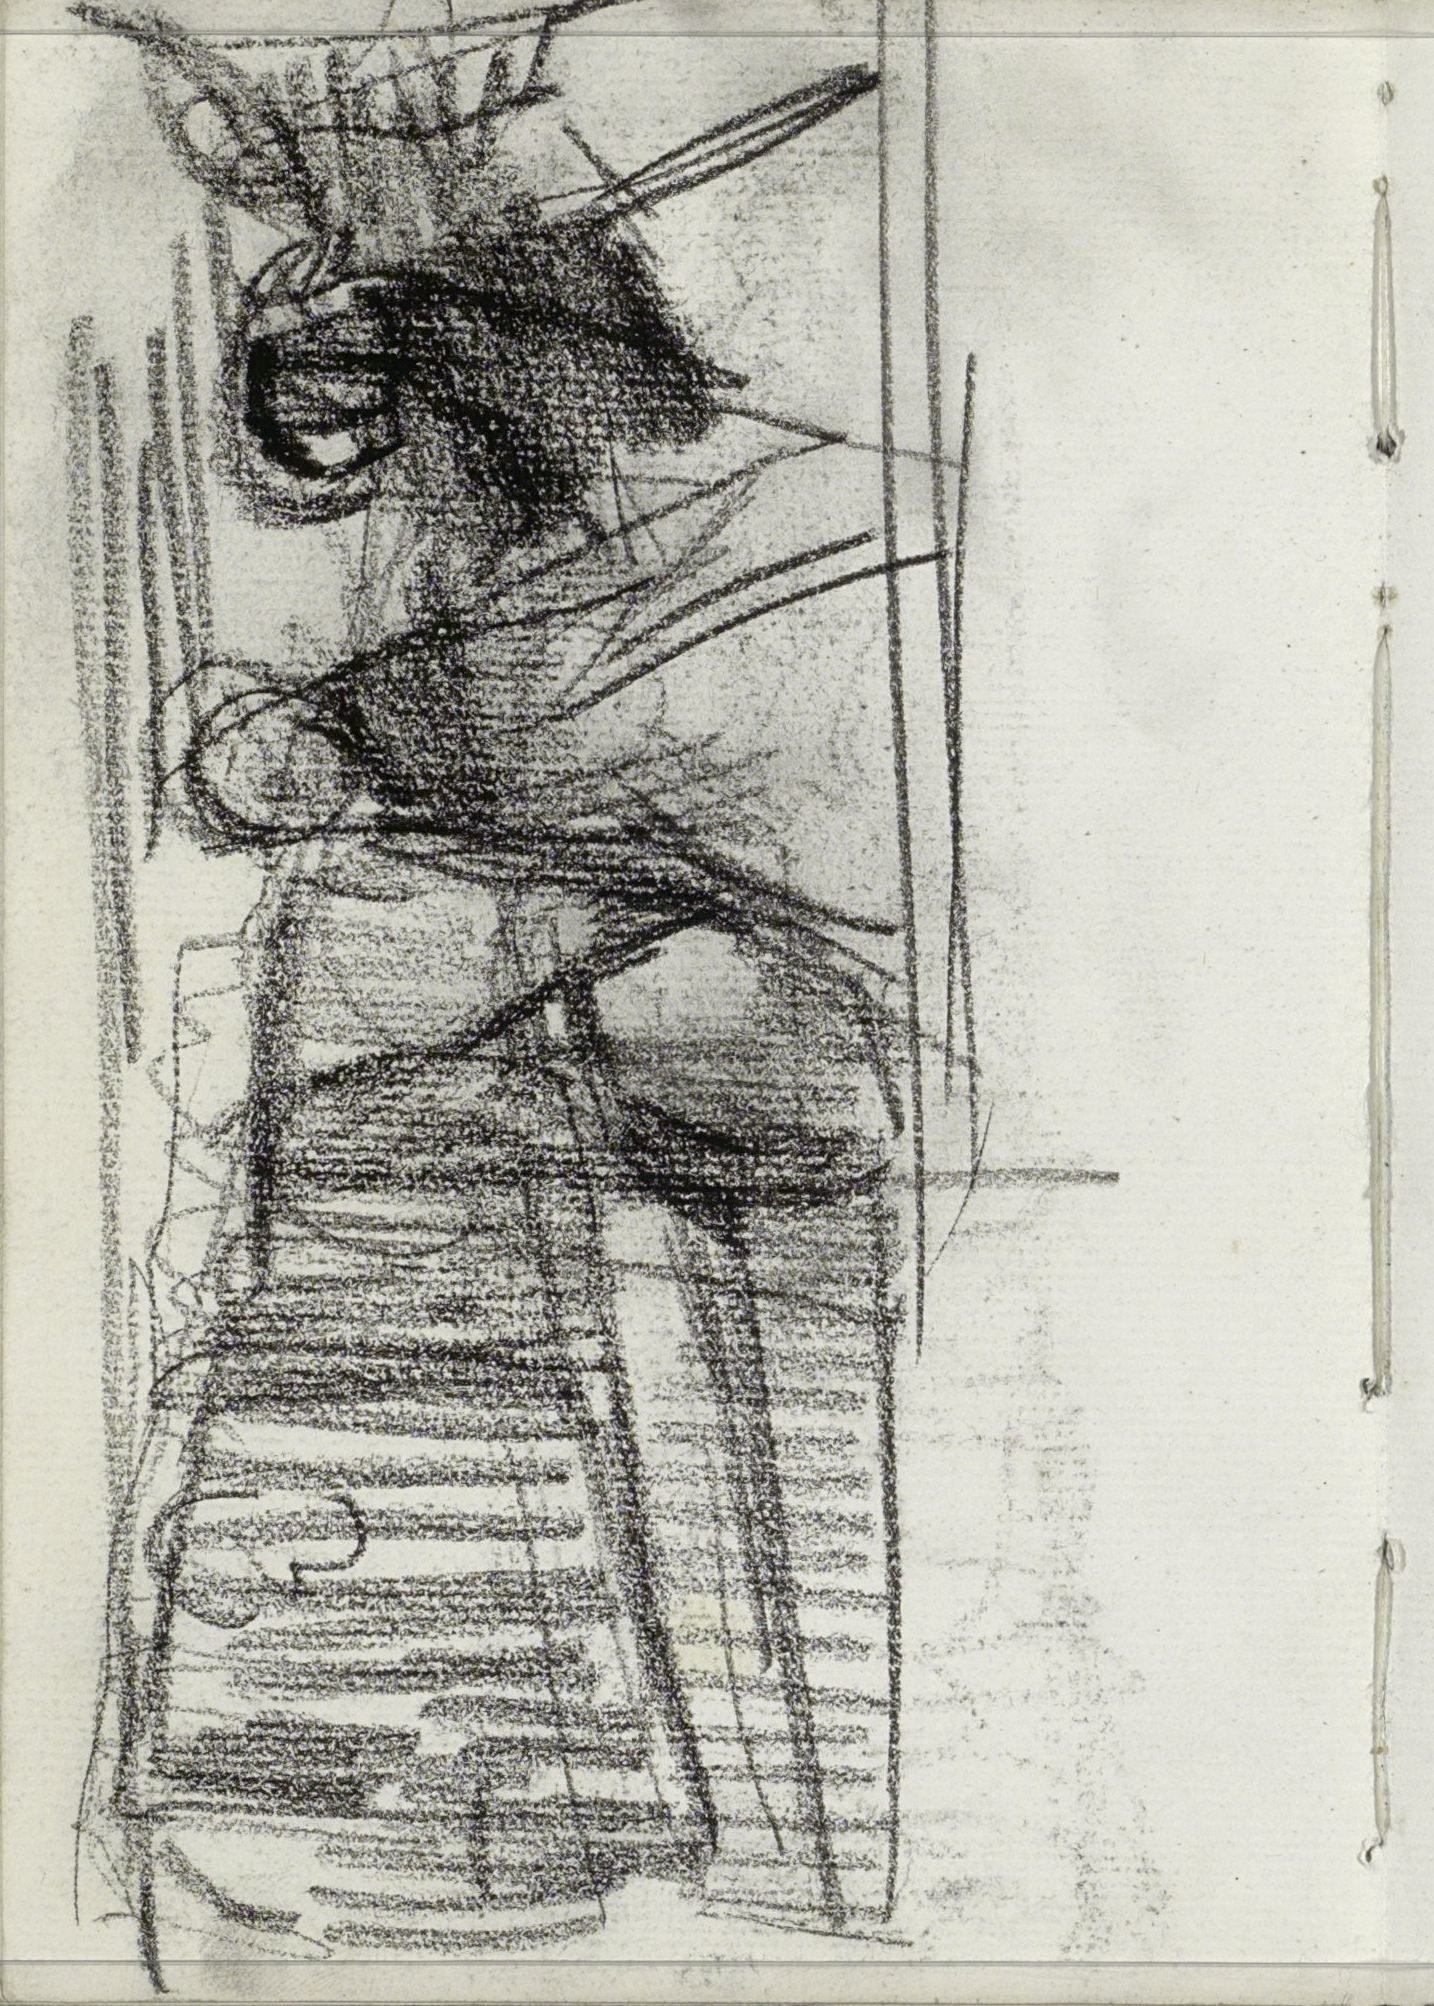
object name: sketchbook leaf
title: Drie vrouwen op een gracht, mogelijk de Prinsengracht te Amsterdam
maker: isaac israels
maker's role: draughtsman, painter, print maker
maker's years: 1865-1934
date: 1886-1903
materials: chalk, paper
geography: amsterdam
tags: adult woman, street (+ city(-scape) with figures, staffage)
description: Pagina 46 uit schetsboek XXXVII met 52 pagina's.